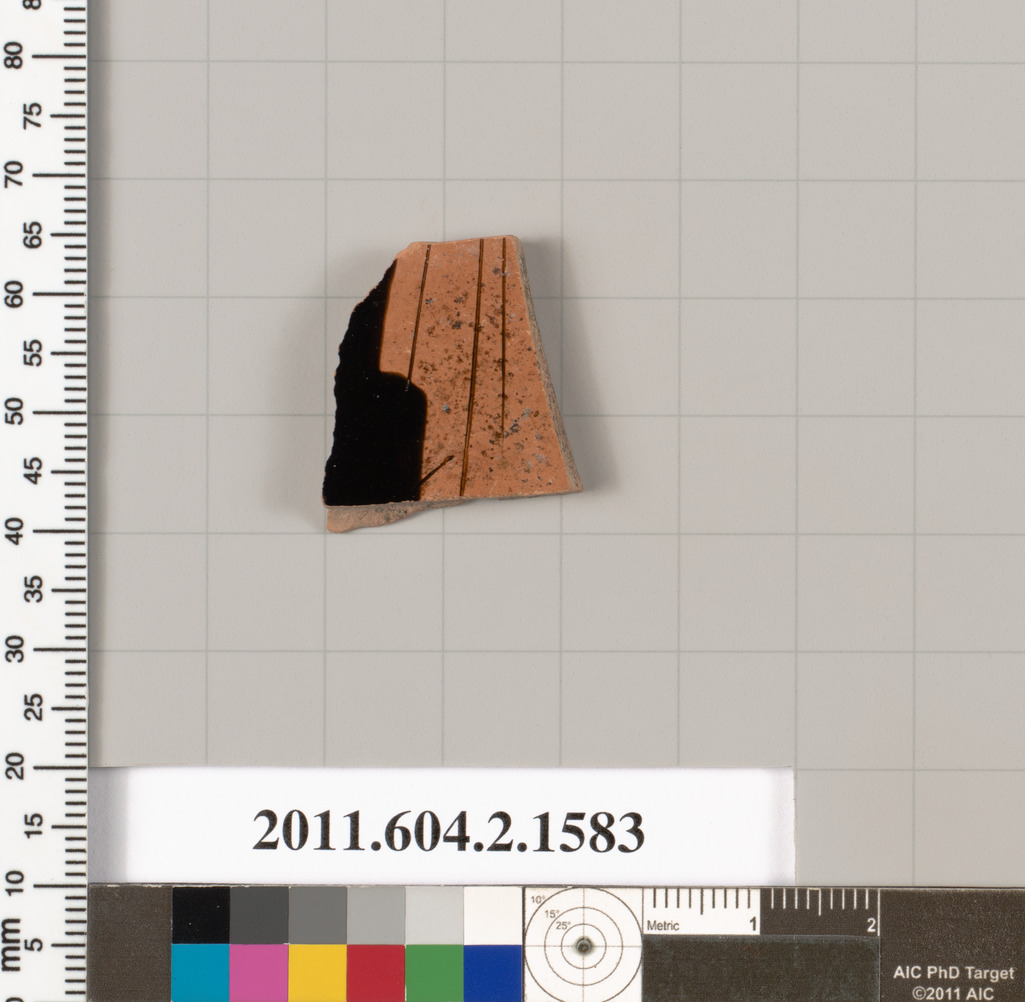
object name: skyphos fragment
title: Terracotta fragment of a skyphos (deep drinking cup)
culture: greek, attic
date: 450-426 BCE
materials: terracotta